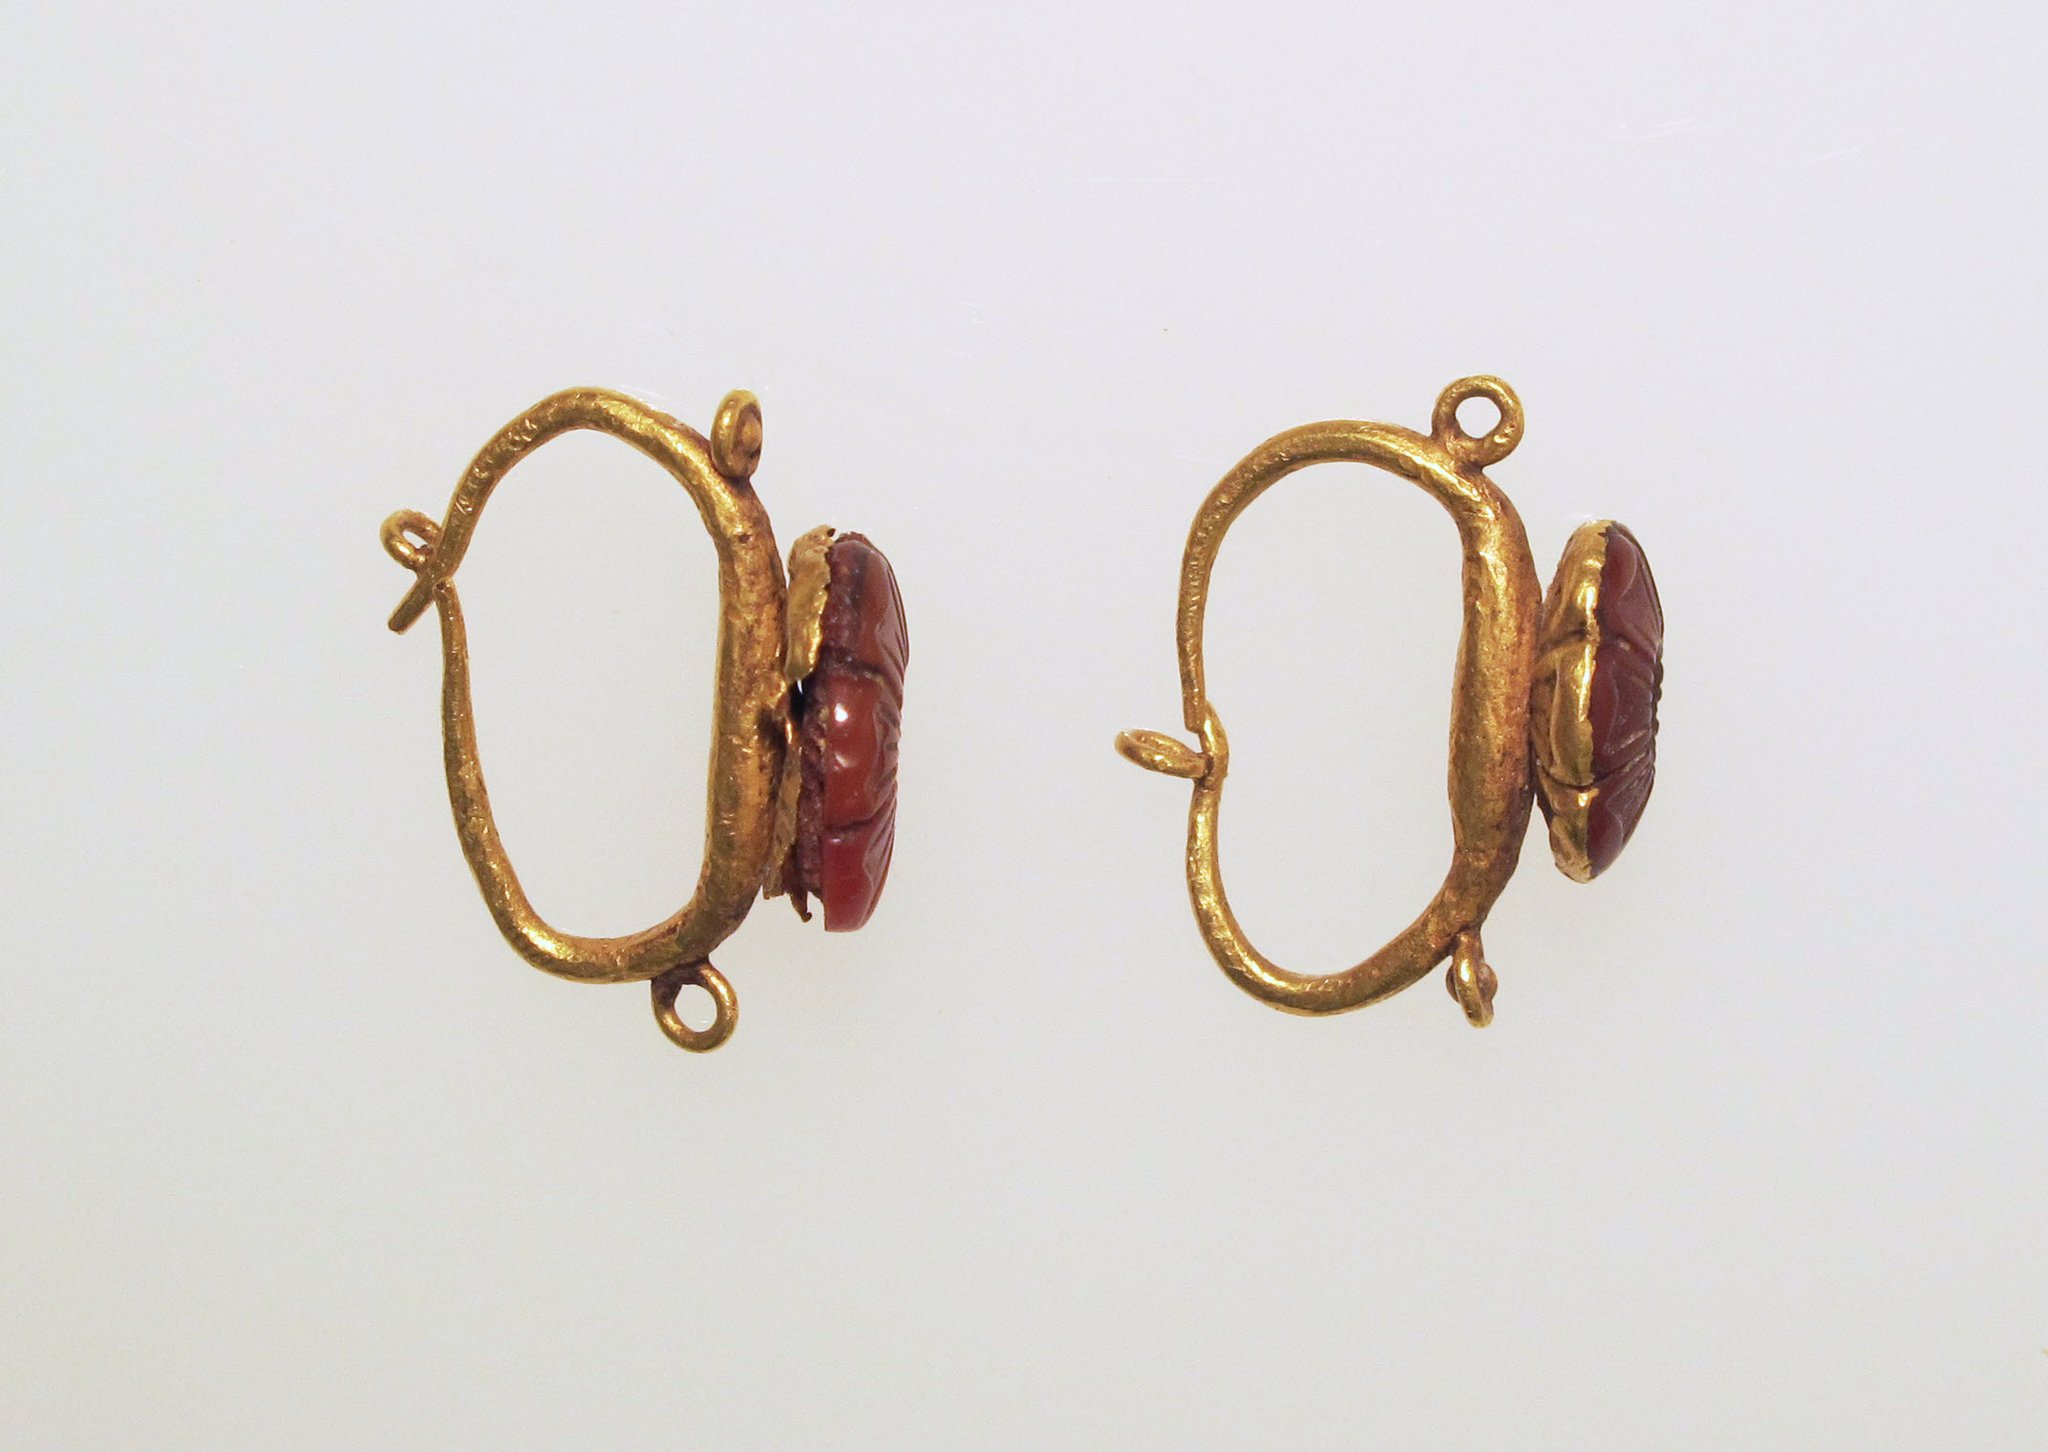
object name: earring with carnelian rosette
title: Earring with carnelian rosettes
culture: roman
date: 670 BCE-330 CE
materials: gemstone, gold